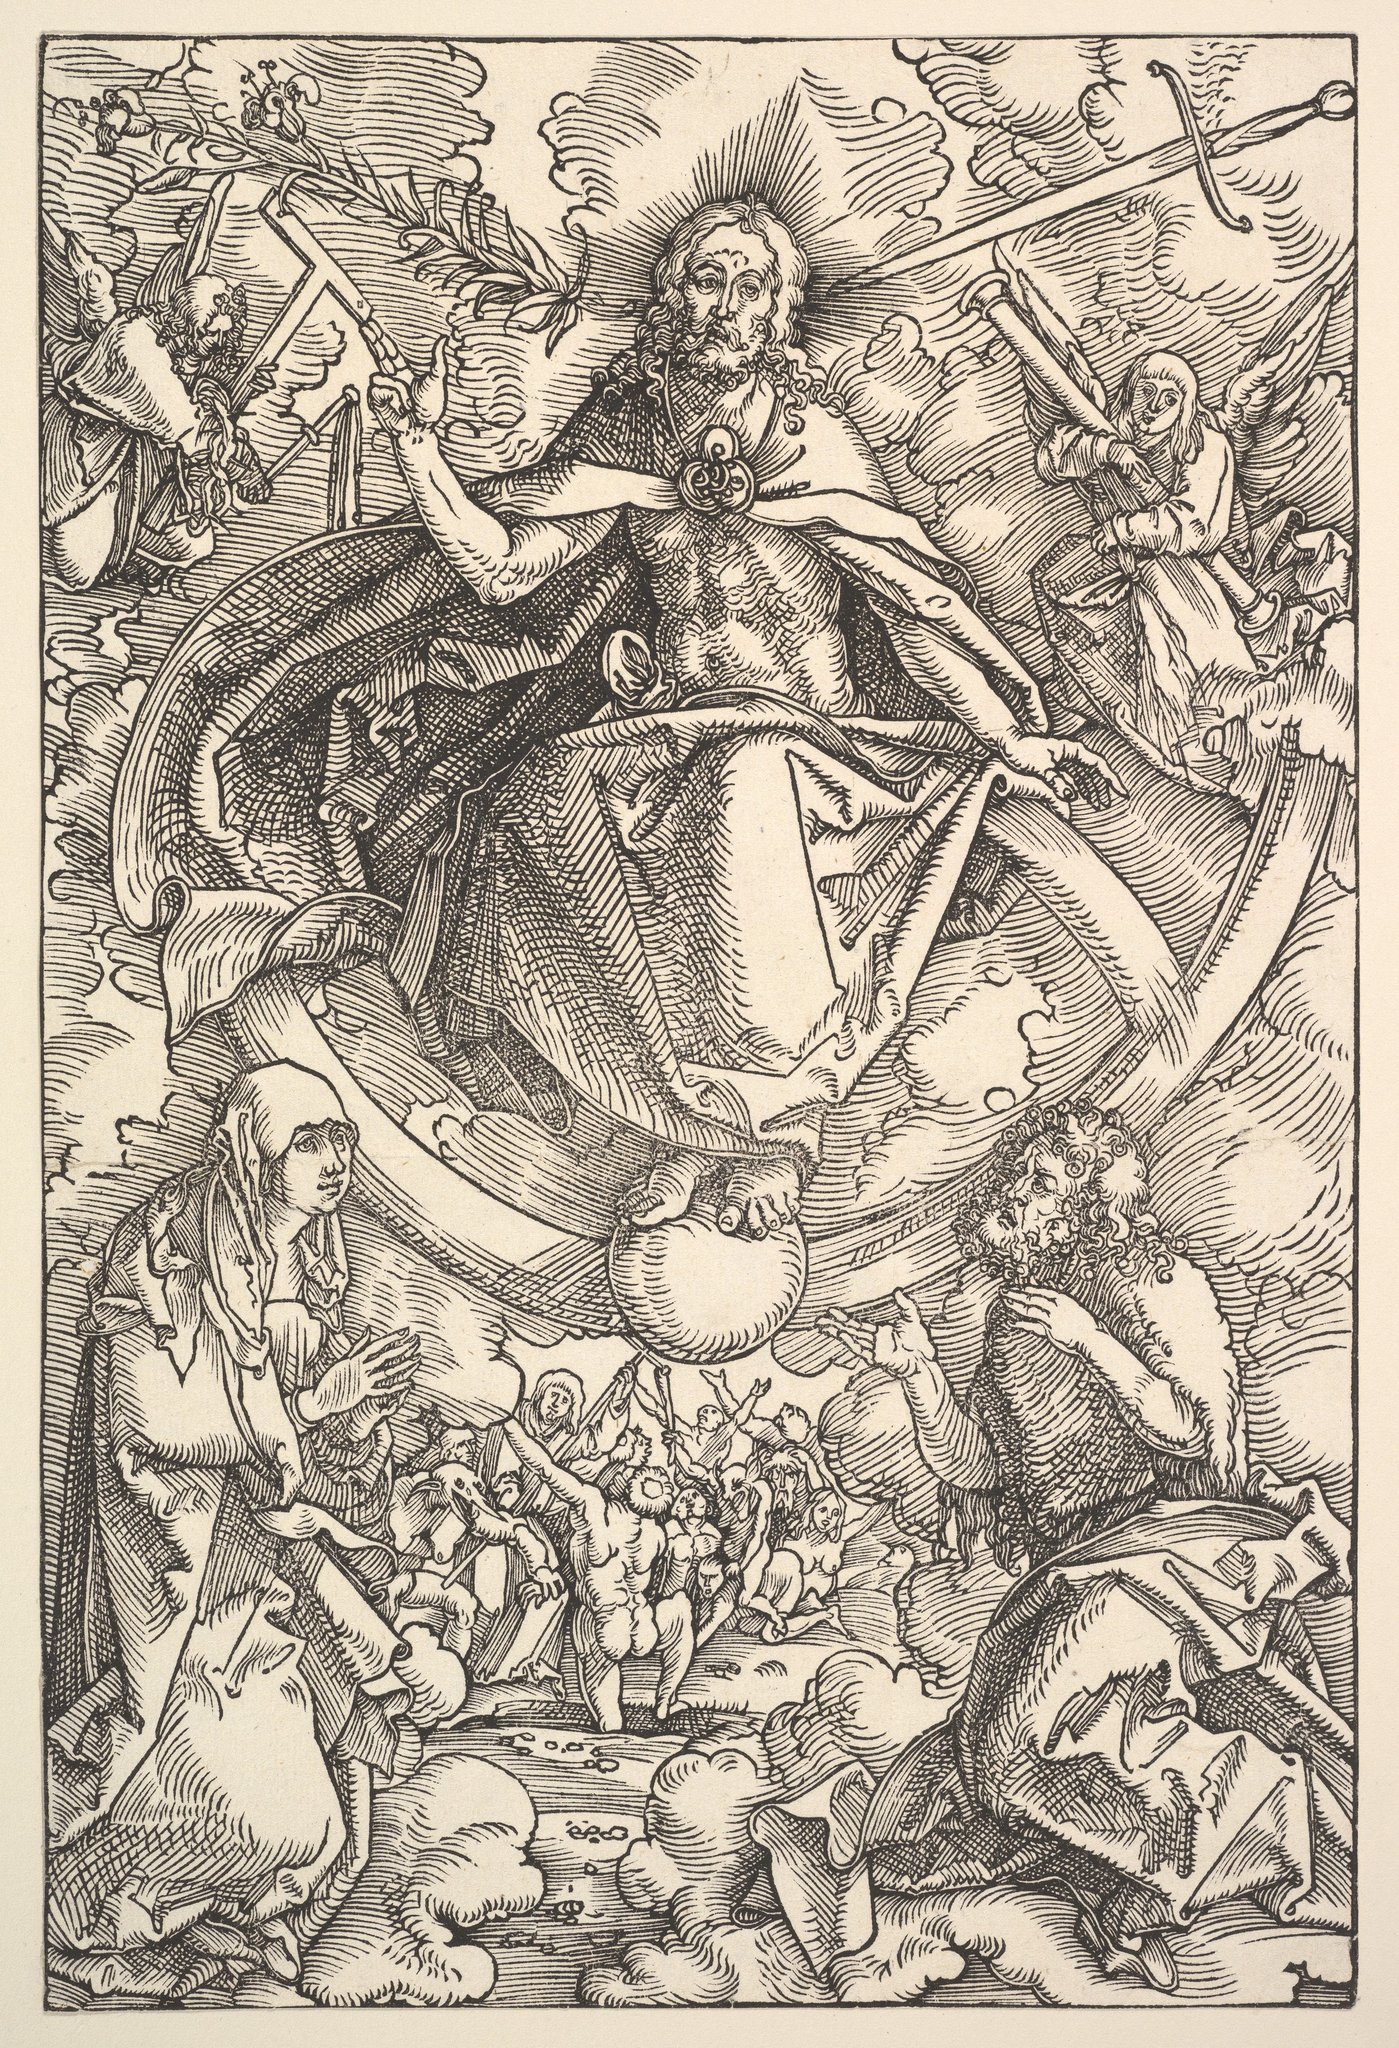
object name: print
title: The Last Judgment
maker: hans baldung (called hans baldung grien)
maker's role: artist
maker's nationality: german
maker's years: 1484-1545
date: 1505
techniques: woodcut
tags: men,angels,christ,last judgement